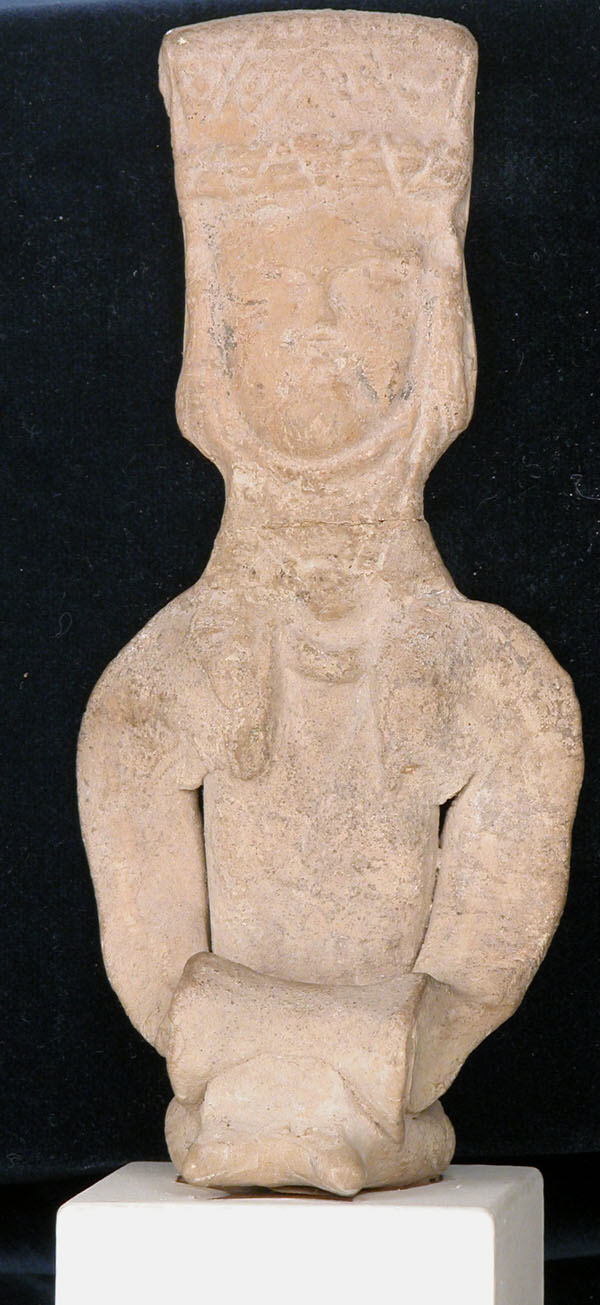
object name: figure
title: Figurine of a Seated Drum Player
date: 1101-1300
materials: earthenware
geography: iran